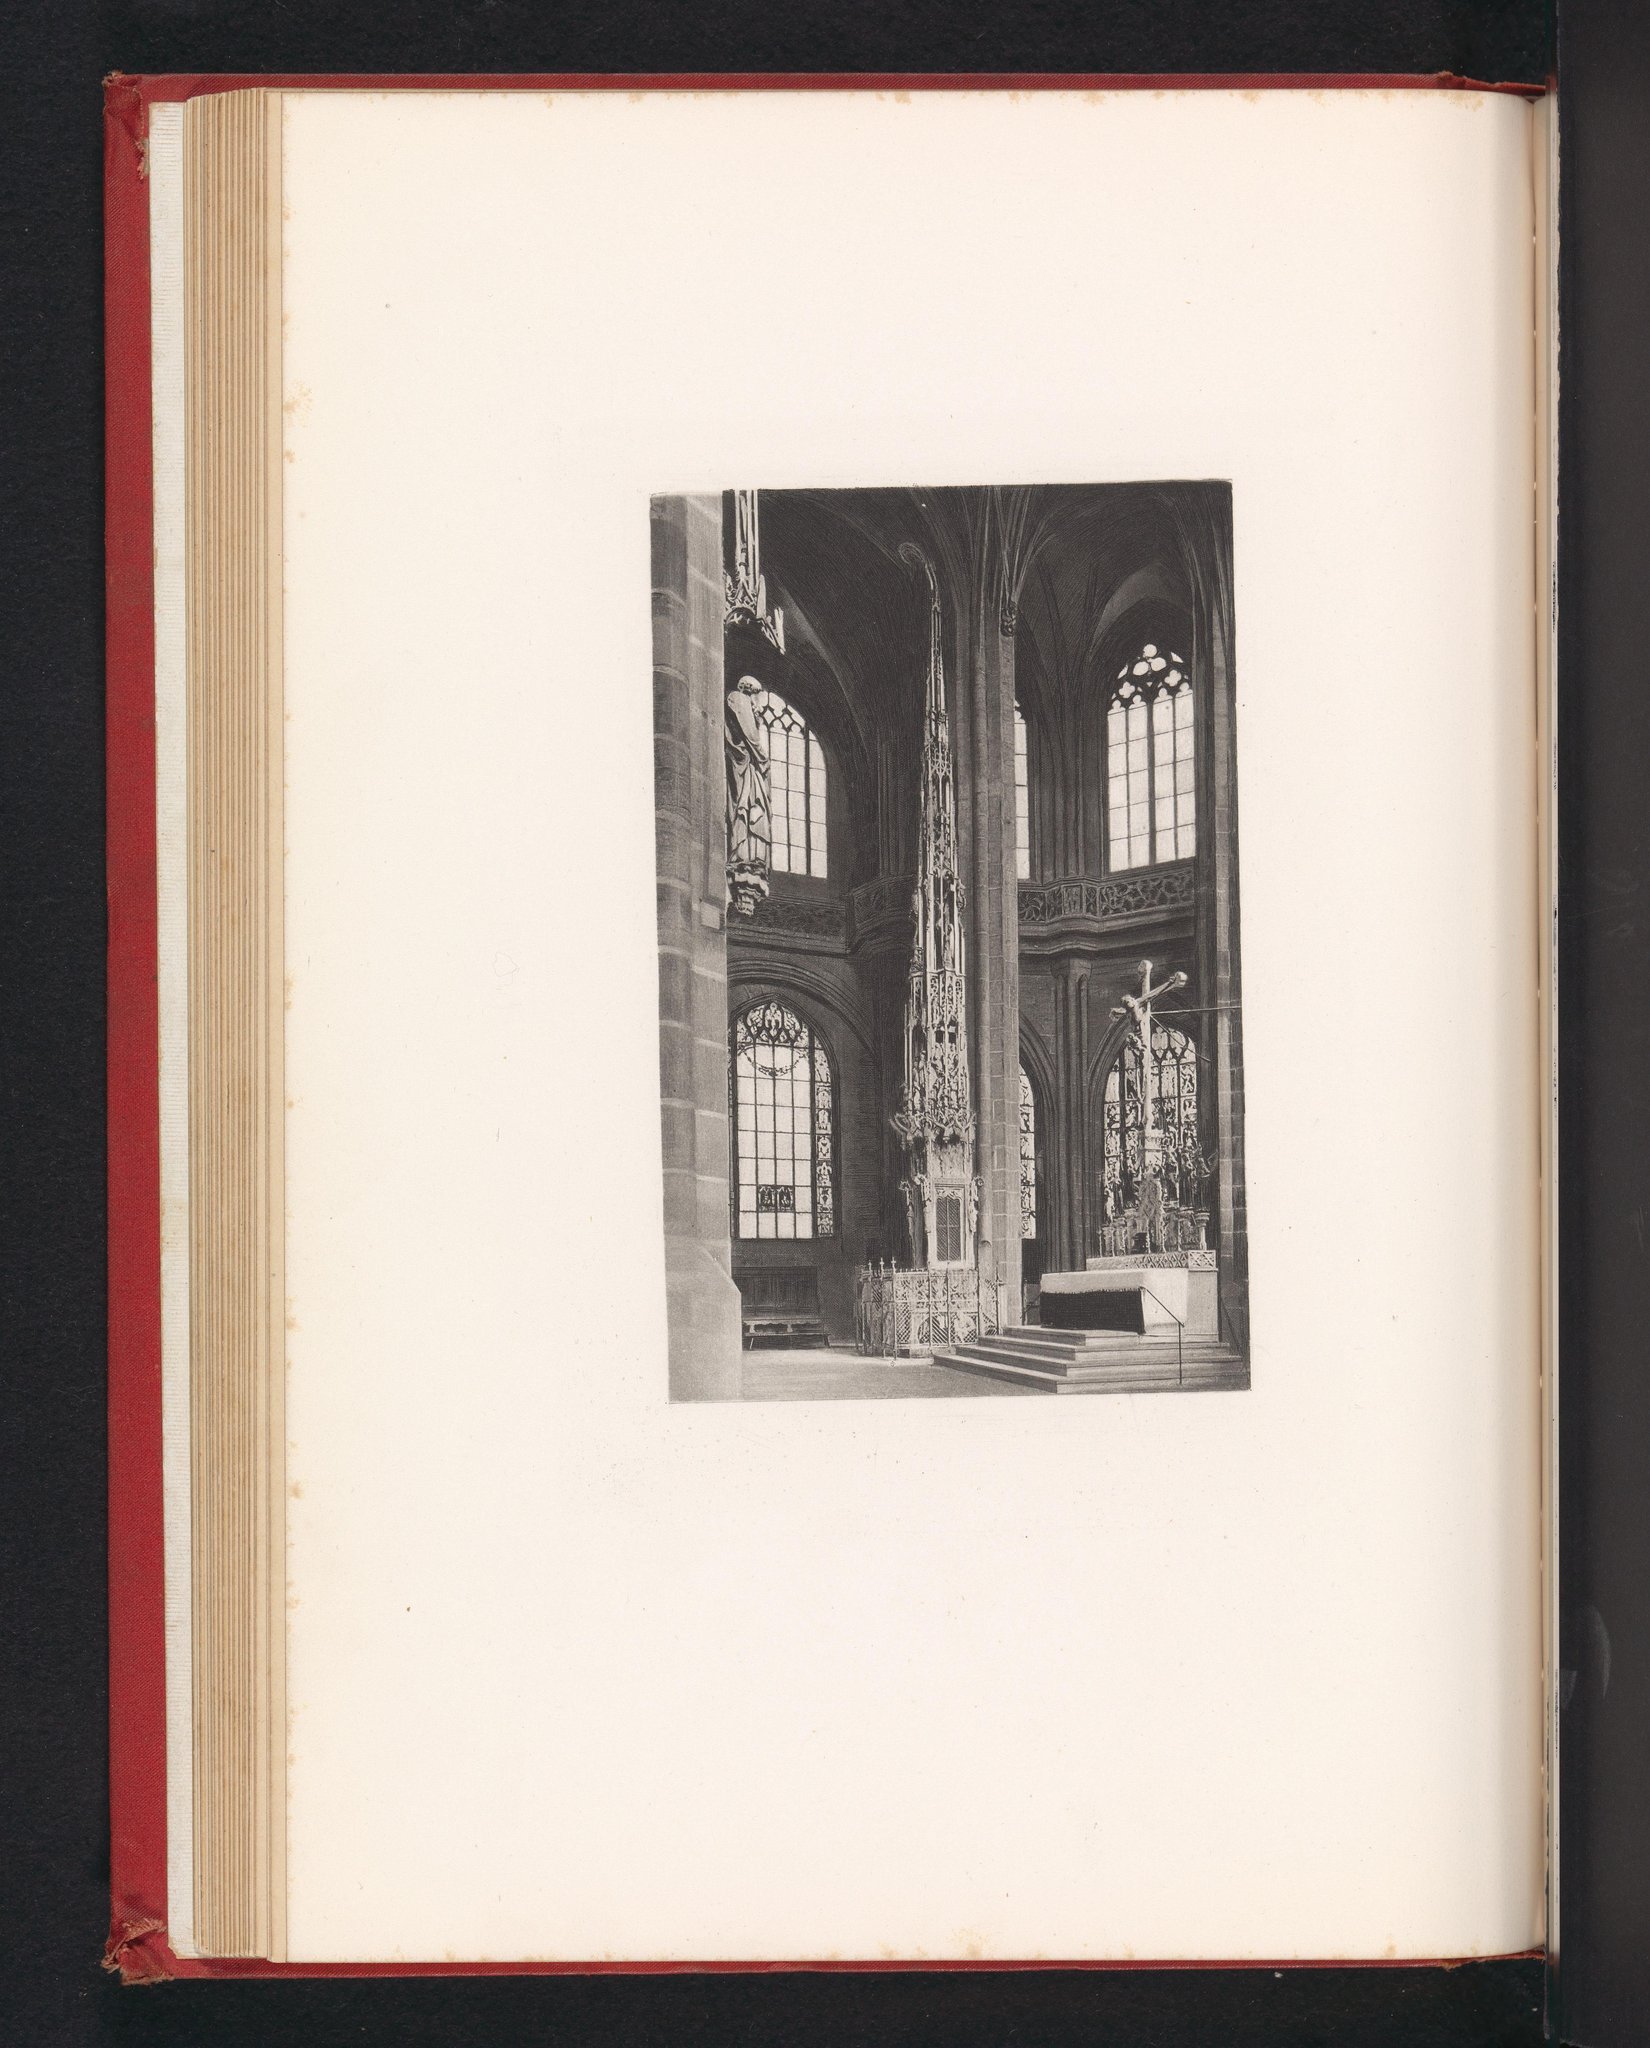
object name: photomechanical print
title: Pyx, Church of St. Lorenz, By Adam Krafft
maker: Anonymous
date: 1878-1888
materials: paper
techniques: photoaquatint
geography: philadelphia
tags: pyx, interior of church